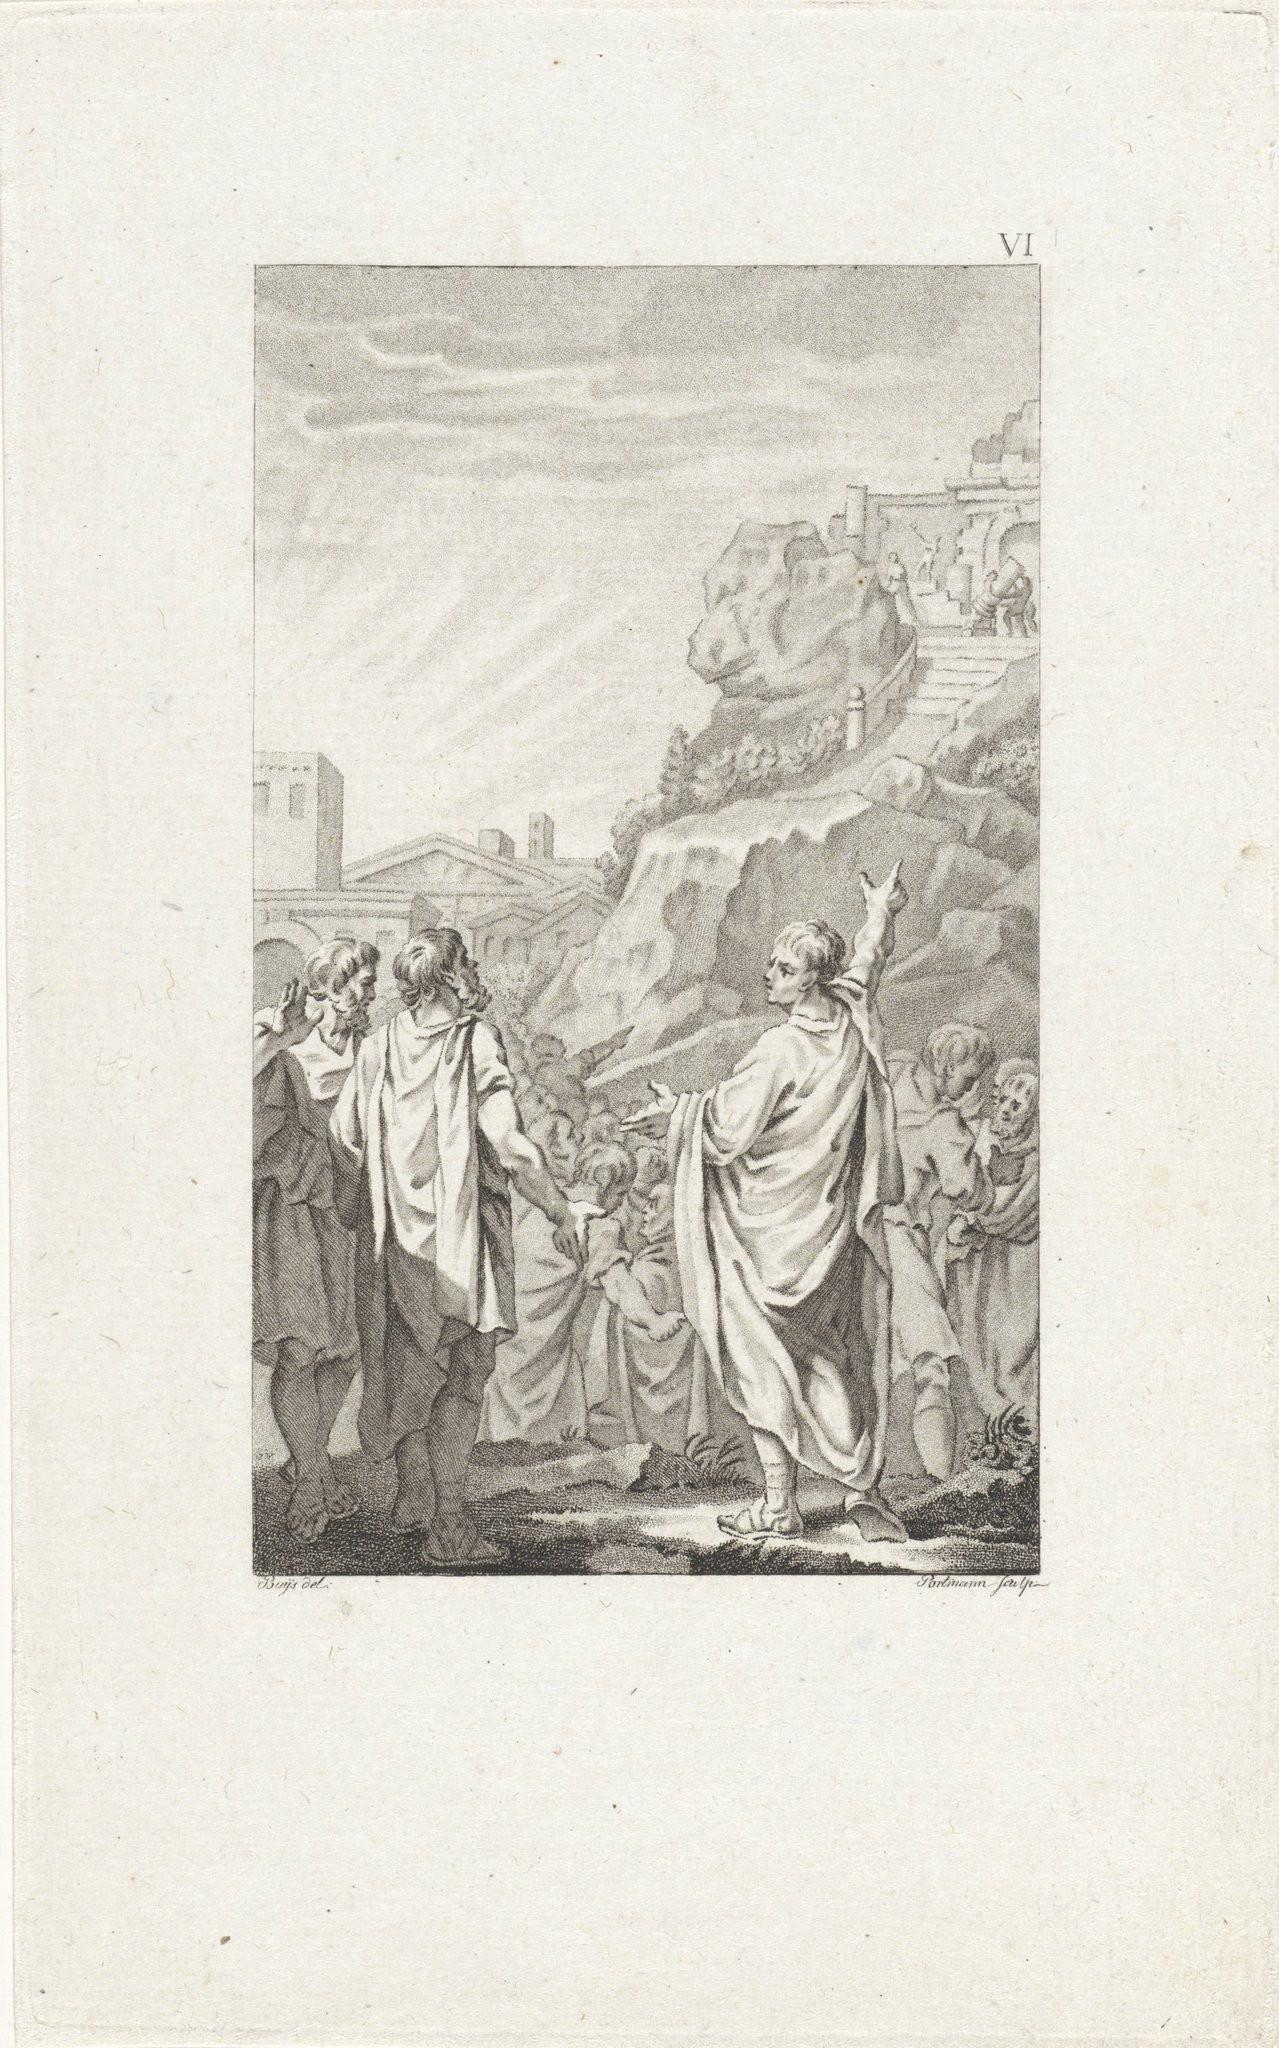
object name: print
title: Publius Valerius Publicola laat een huis bouwen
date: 1793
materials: paper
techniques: etching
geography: utrecht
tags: male persons from classical history (poplicola) - non-aggressive activities of person from classical history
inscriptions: collector's mark: Lugt 2228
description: Nadat Publius Valerius Publicola na de dood van Brutus nog als enige consul aan de macht is laat hij op de heuvel Velia een huis bouwen. Het volk komt echter in opstand waarop hij besluit zijn huis te verplaatsen naar de voet van de berg.